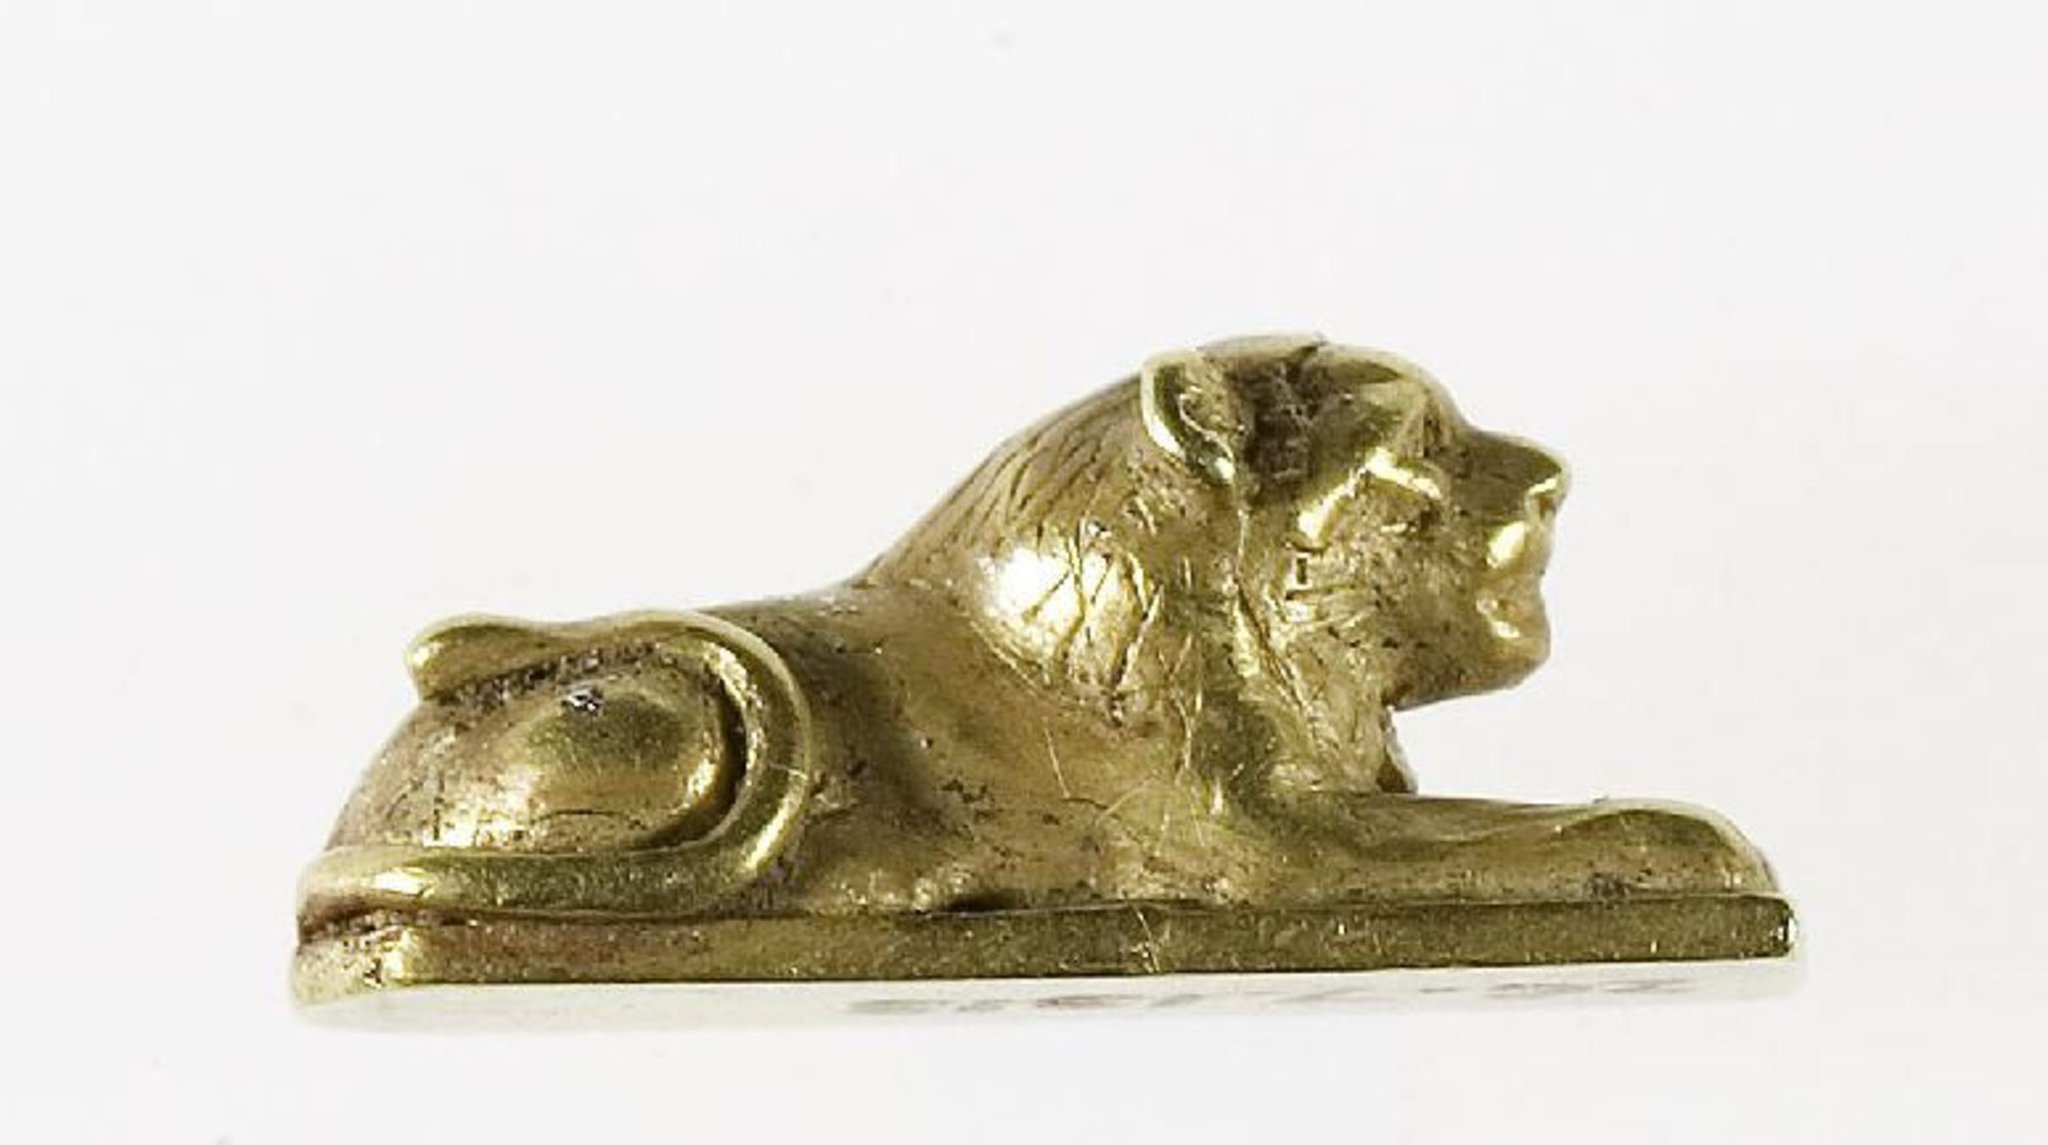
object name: ornament, lion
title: Recumbent lion from a bracelet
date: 1878-1805 BCE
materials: gold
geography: memphite region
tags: lions